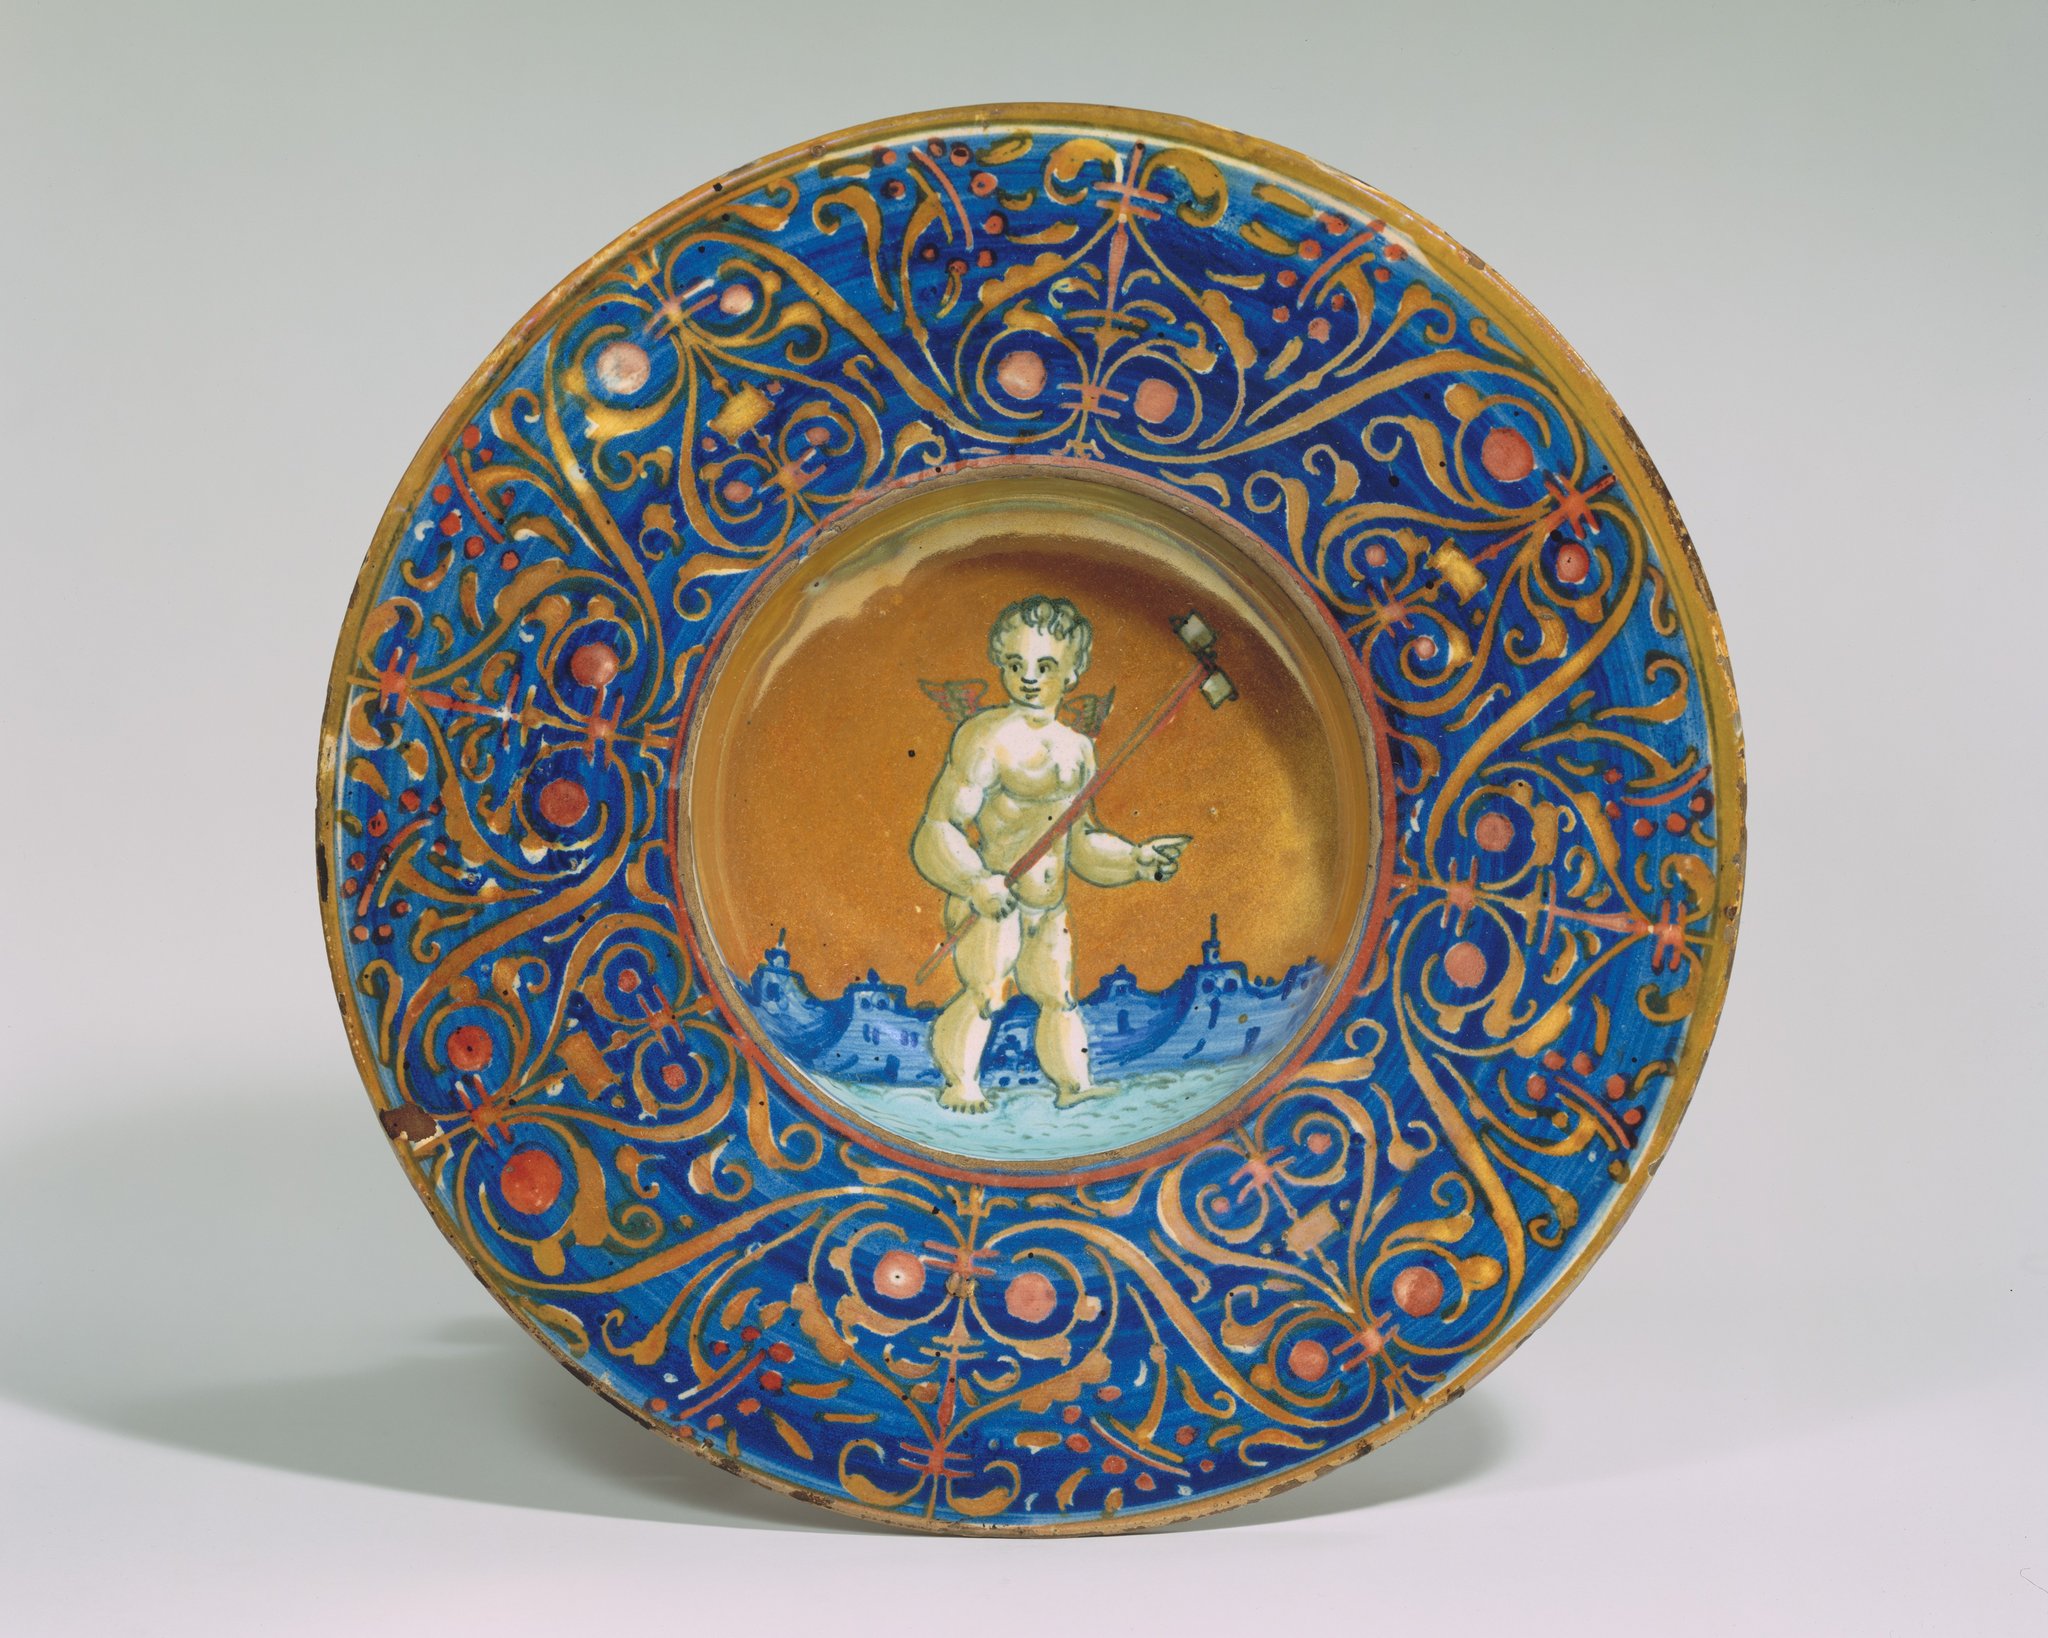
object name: dish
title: Dish (tondino)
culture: italian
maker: italian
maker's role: artist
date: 1530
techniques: maiolica, glazing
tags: putti